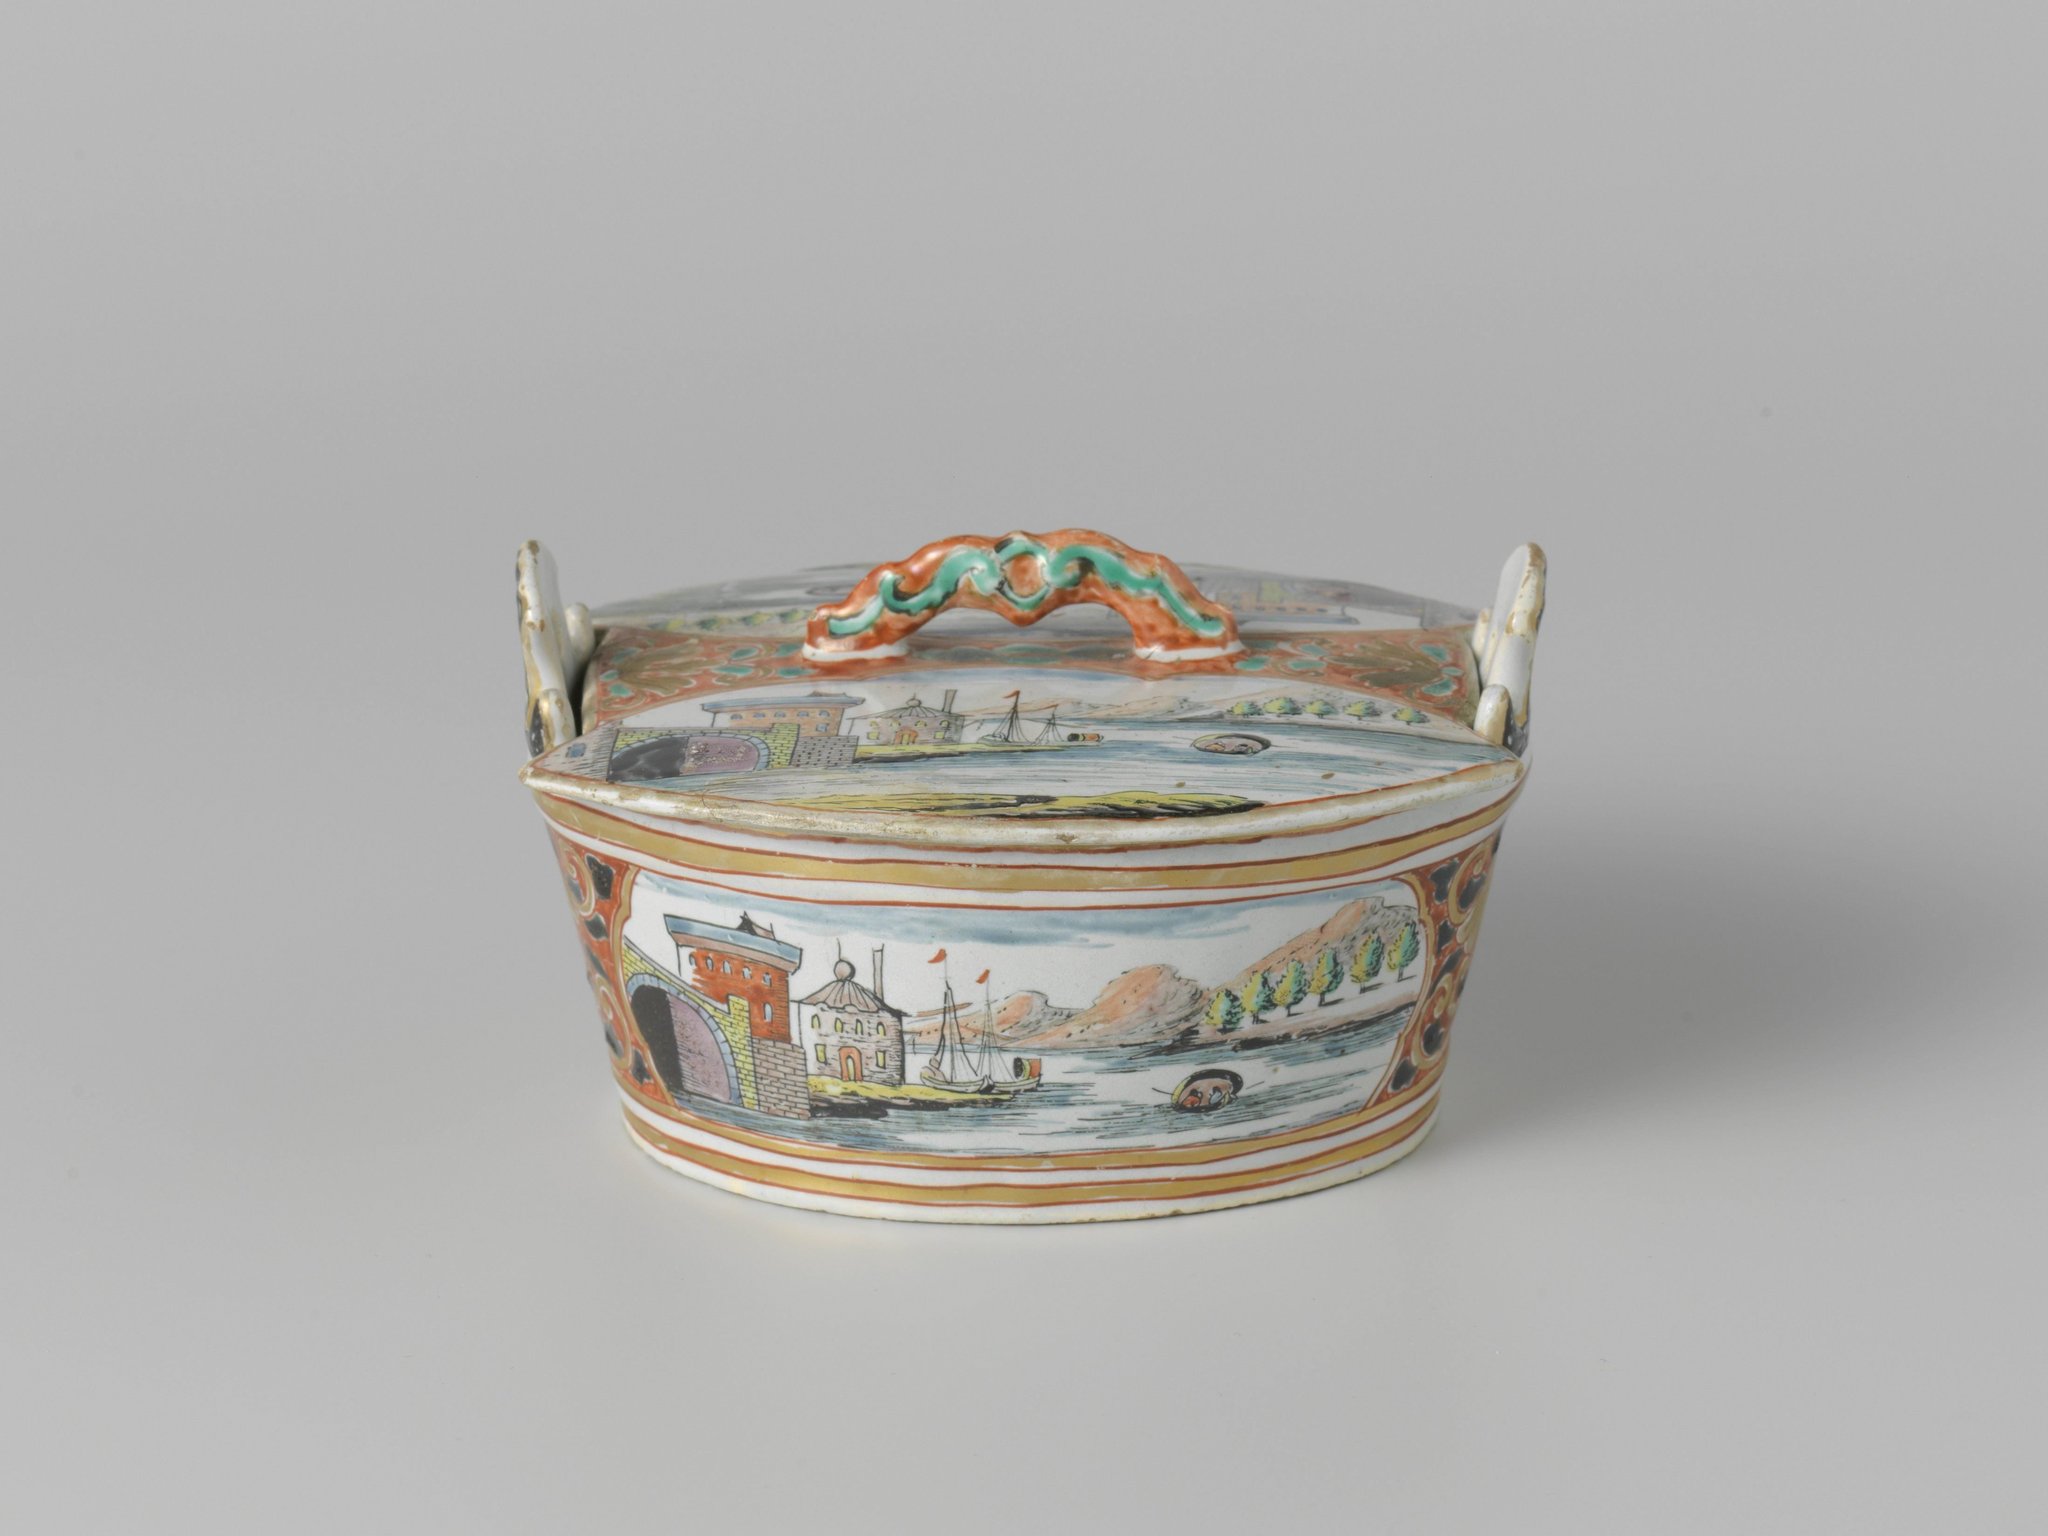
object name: butter dish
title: Botervloot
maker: Anonymous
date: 1740-1765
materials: faience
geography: delft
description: Botervloot van faience. De deksel van de vloot is mogelijk later gemaakt.